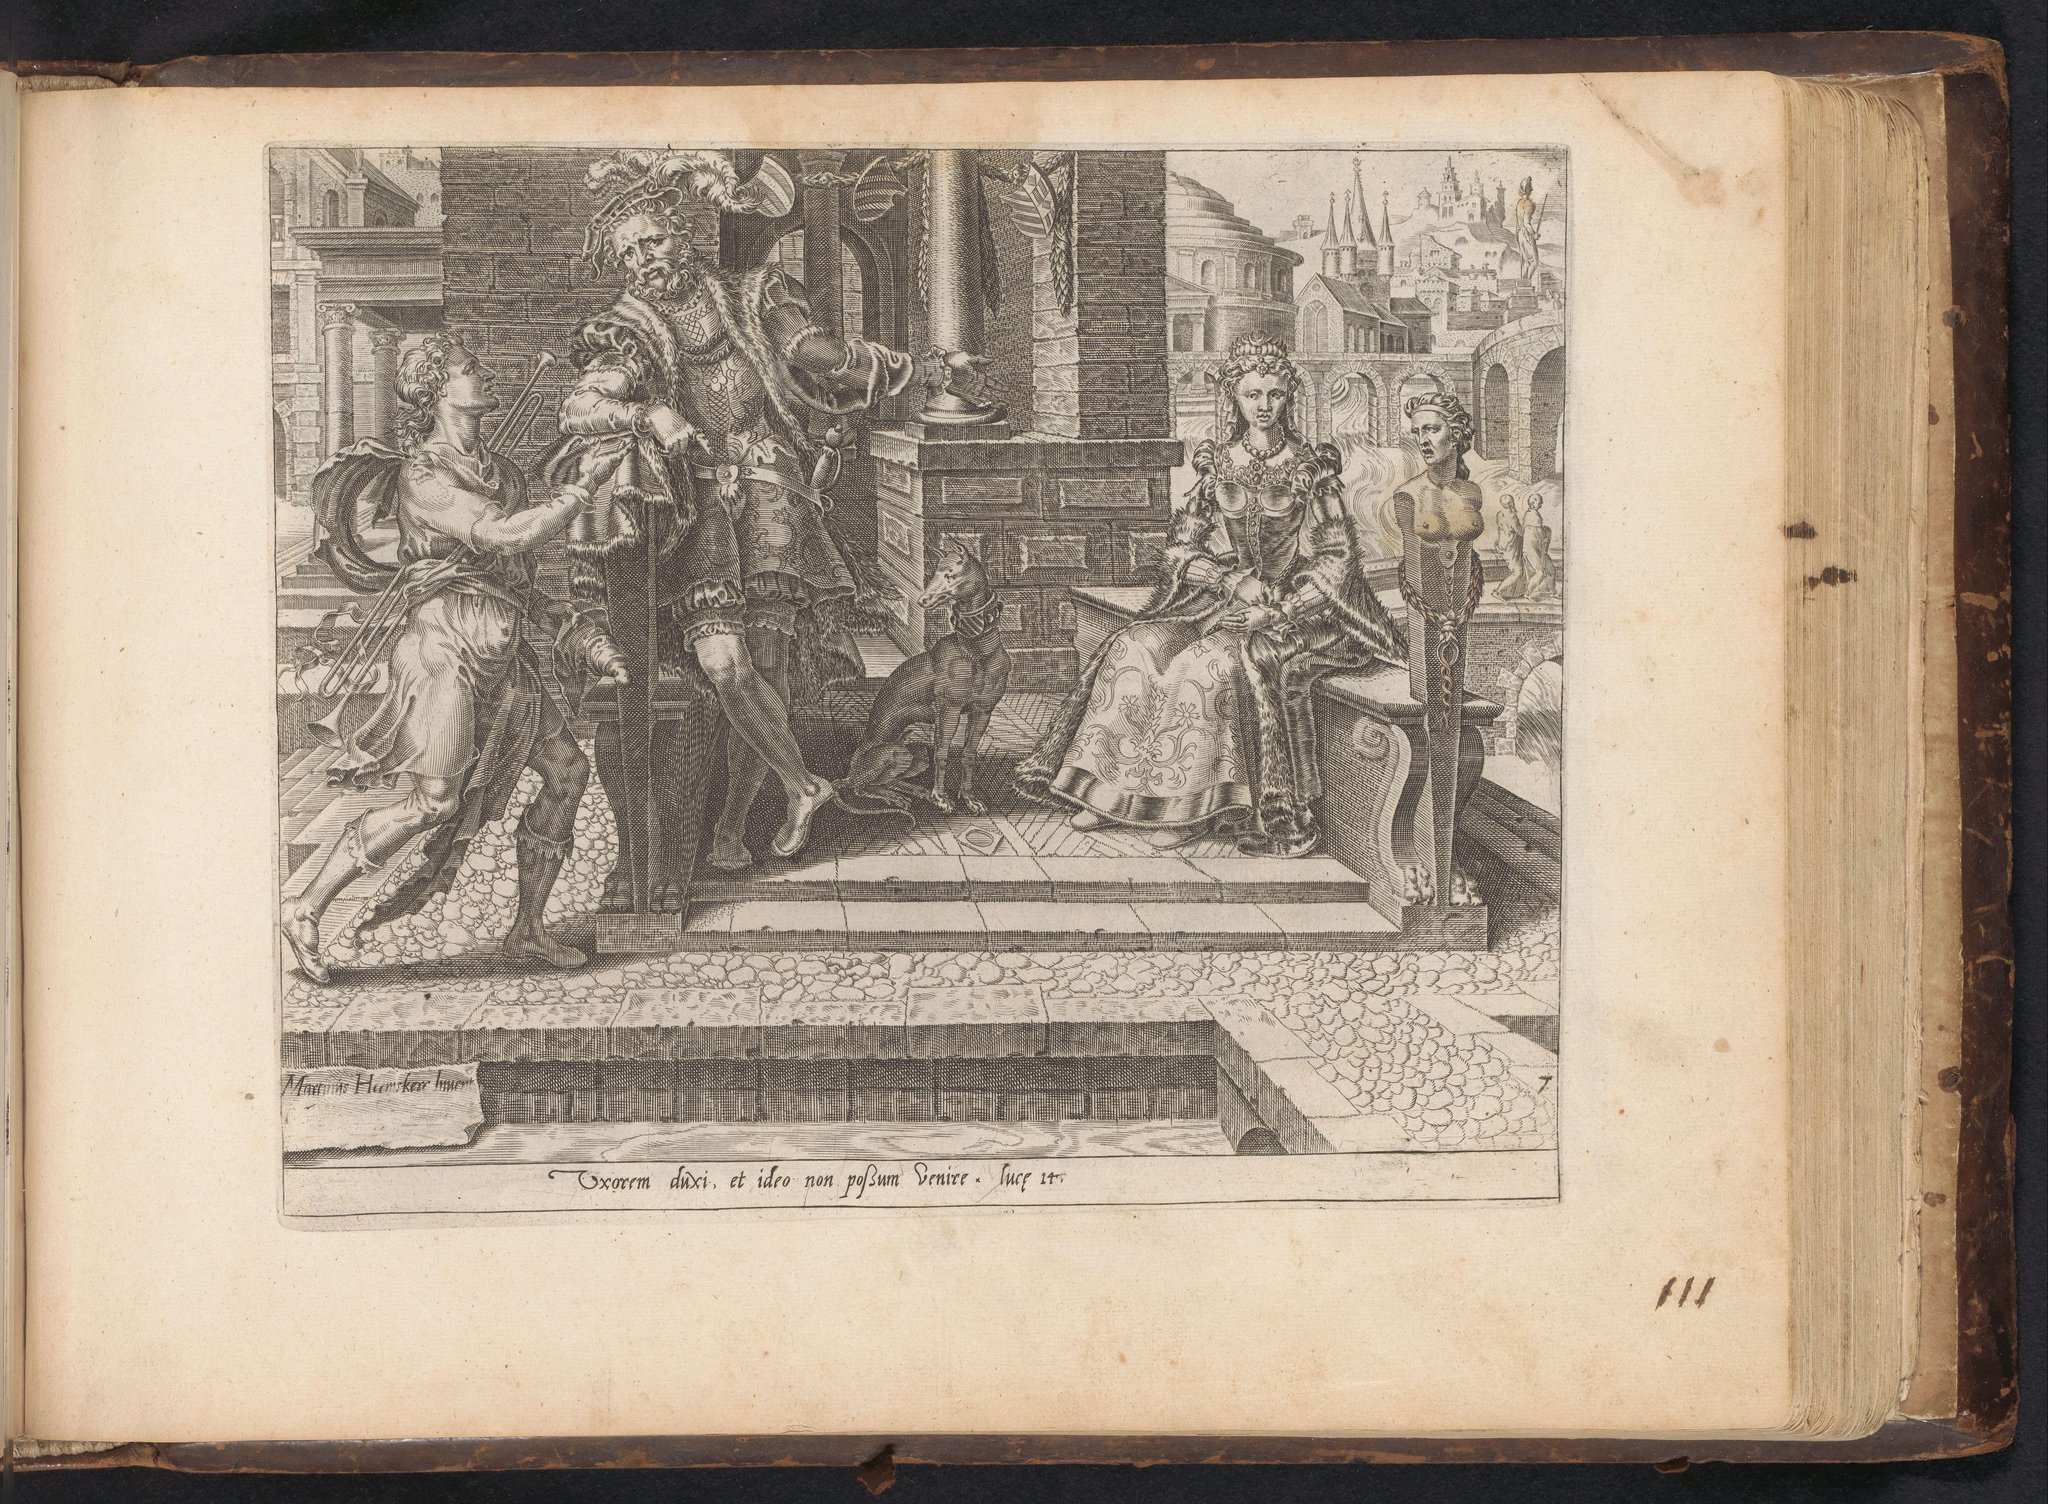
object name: album leaf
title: Van d'Inrydingh Iesu, en eenige geschiedenissen daer op gevolcht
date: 1558-1559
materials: paper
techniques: engraving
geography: alkmaar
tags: those that are invited to the royal wedding-feast excuse themselves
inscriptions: number: ‘111’, serial number: ‘7’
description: Een dienaar van de koning komt bij de derde gast en nodigt hem uit voor het bruiloftsfeest. De gast verontschuldigt zich met het excuus dat hij pas getrouwd is. Hij wijst naar zijn bruid. Onder de voorstelling een verwijzing in het Latijn naar de Bijbeltekst in Luc. 14. Deze prent maakt deel uit van een album.